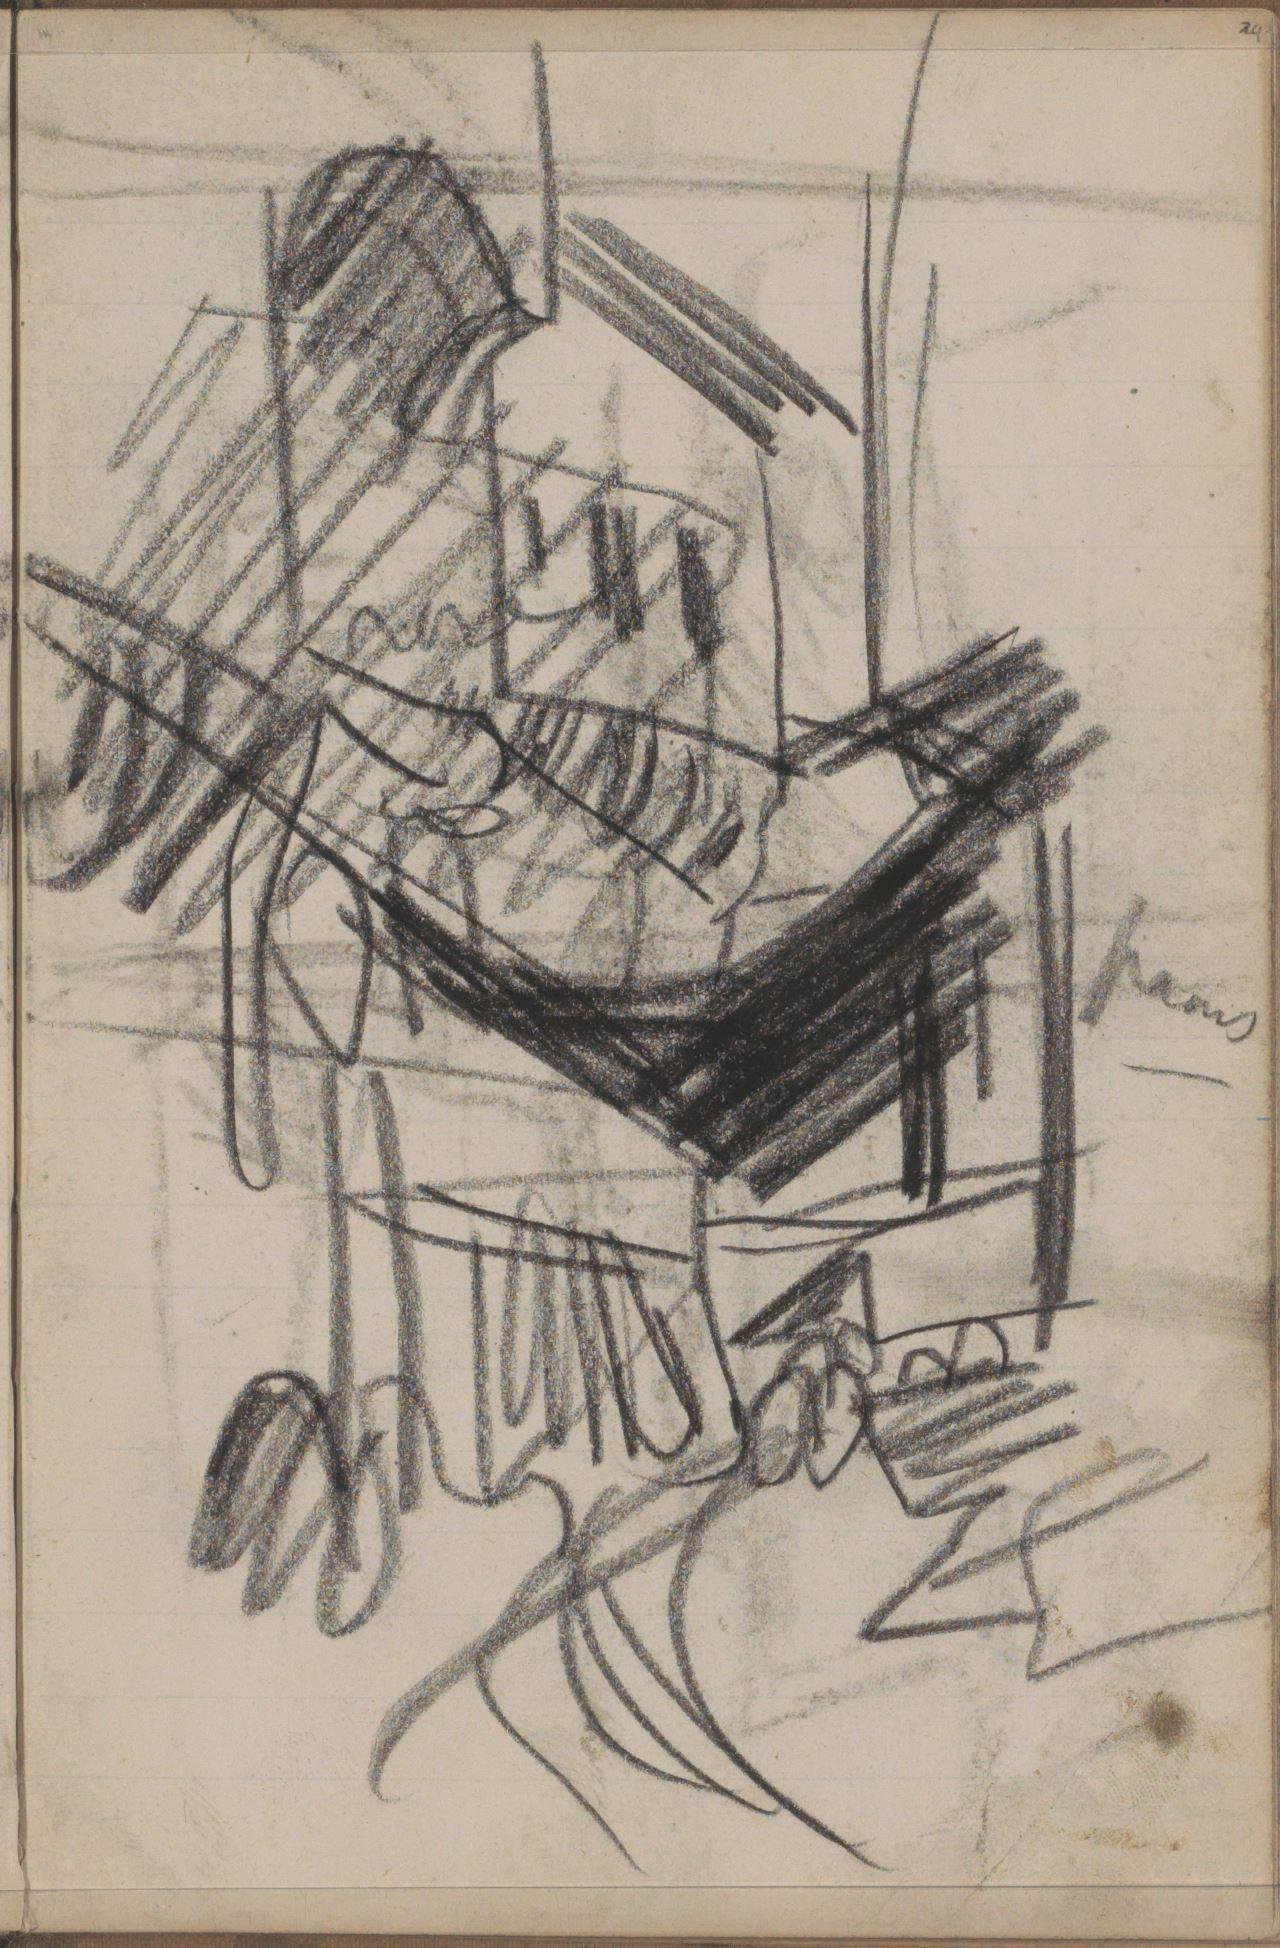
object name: sketchbook leaf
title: Studieblad met huizen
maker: marius bauer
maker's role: draughtsman, print maker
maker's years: 1867-1932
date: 1888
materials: chalk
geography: istanbul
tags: architecture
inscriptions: kleurnotitie, handgeschreven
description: Pagina 24 uit een schetsboek met 56 bladen.